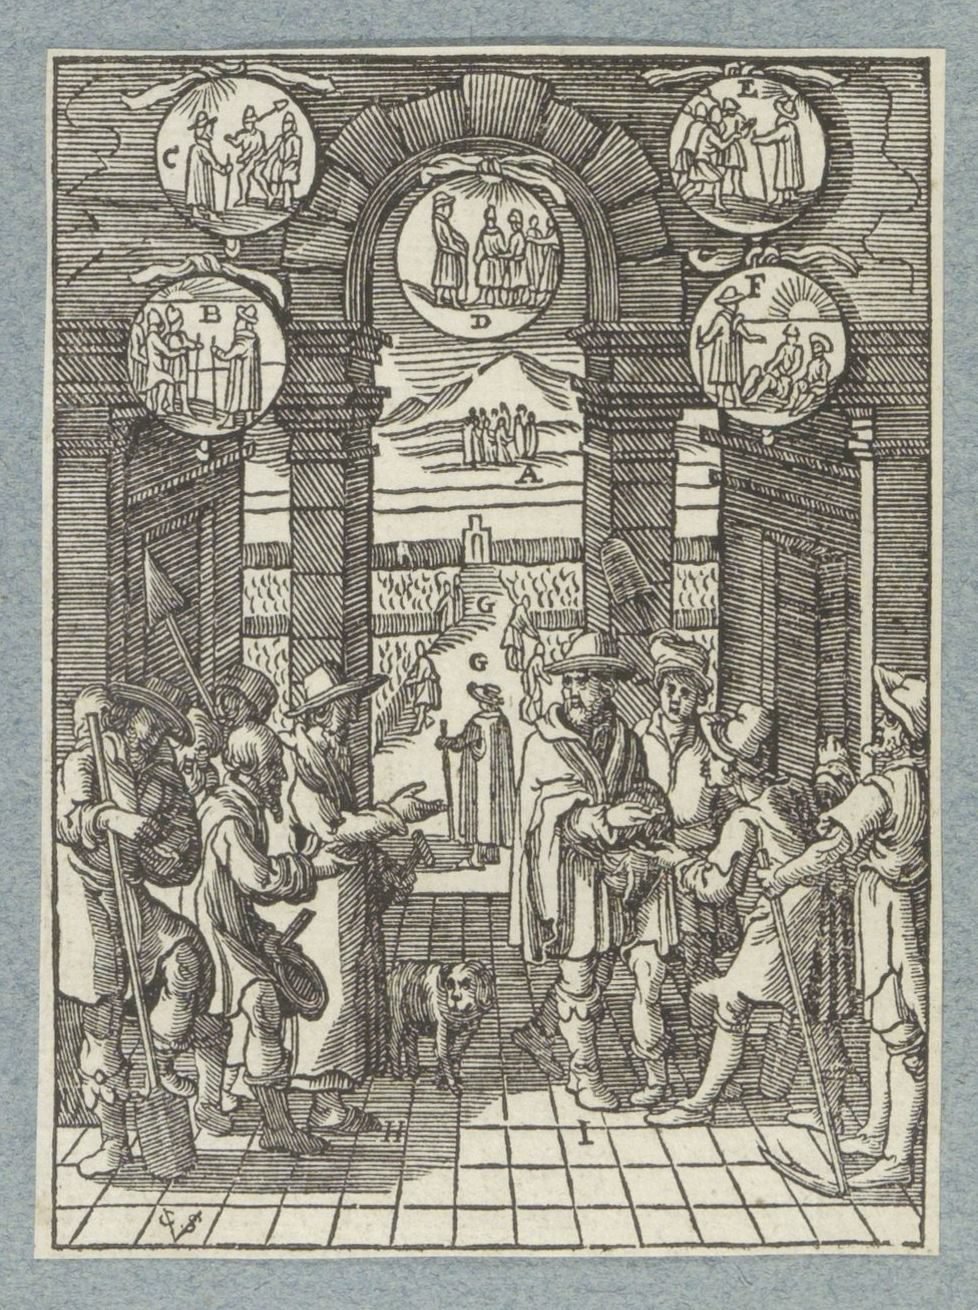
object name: book illustration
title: Gelijkenis van de arbeiders in de wijngaard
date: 1629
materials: paper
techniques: letterpress printing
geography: amsterdam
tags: the labourers in the vineyard ~ parable of christ (matthew 20:1-16), at the end of the day the lord pays all the labourers equally; those that worked all day object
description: De arbeiders ontvangen na hun werk in de wijngaard het loon van één denarie van de rentmeester van de landheer. Bovenaan de gevel medaillons waarin getoond wordt hoe de landheer zowel in de morgen als om drie uur, zes uur en negen uur arbeiders inhuurt. De tijden zijn af te lezen aan de stand van de zon op de horizon. De rentmeester geeft iedere arbeider even veel geld. Bij verschillende elementen uit de voorstelling staan letters. De prent maakt deel uit van een album.